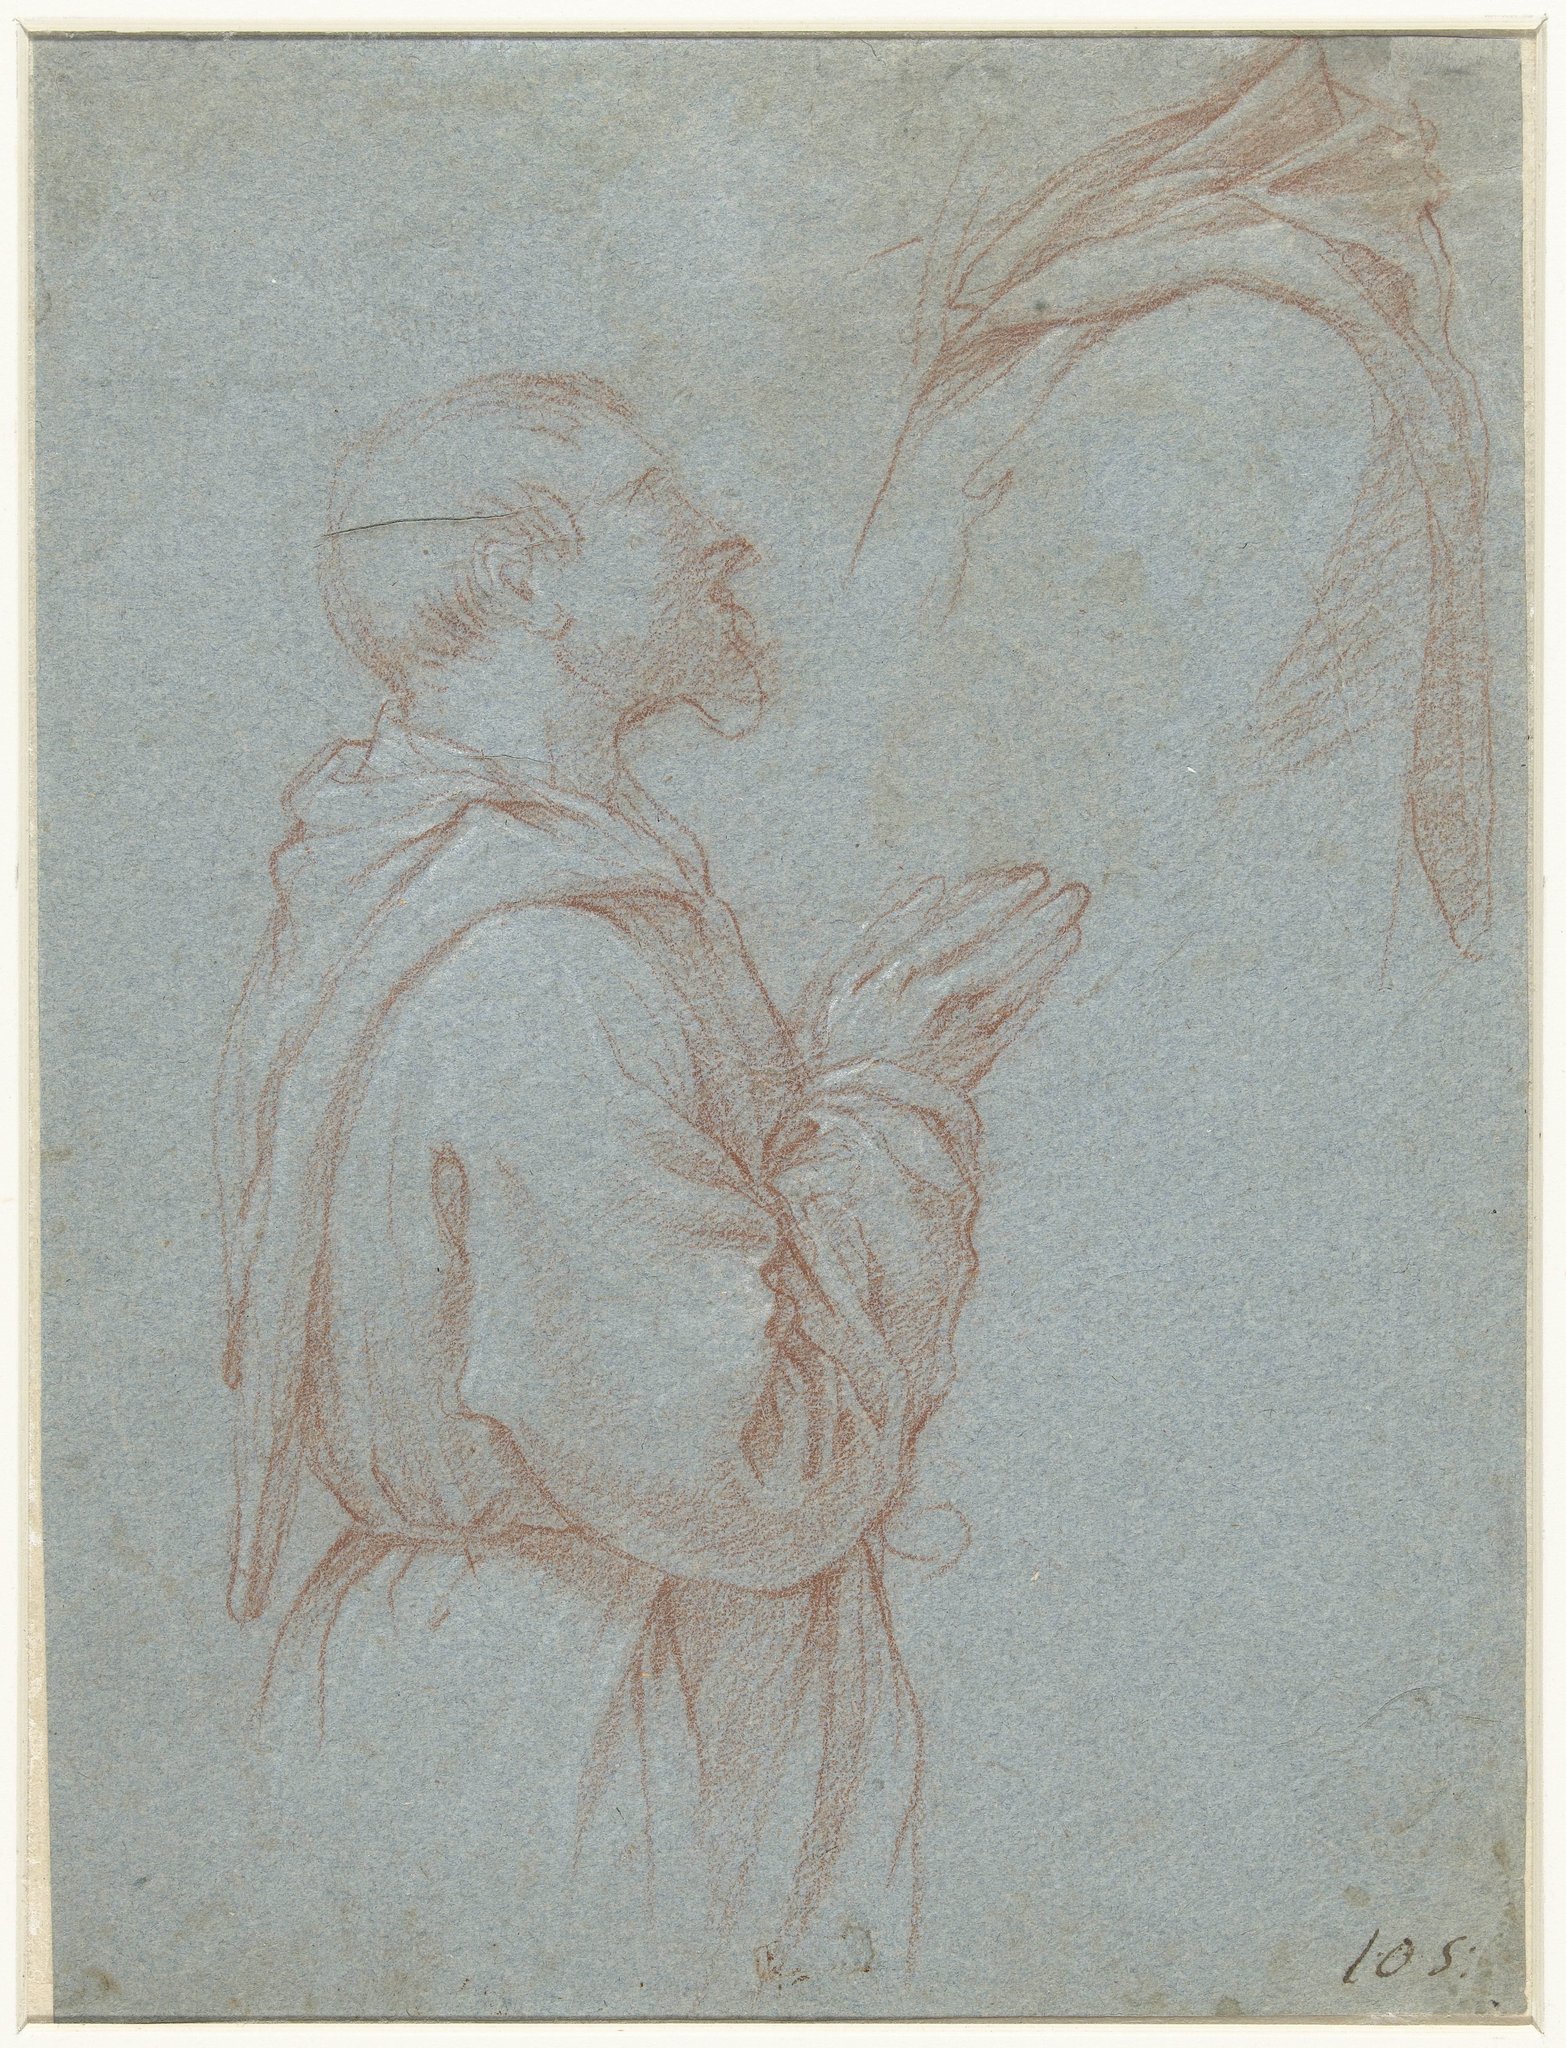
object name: drawing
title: Biddende monnik, en profil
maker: carlo maratta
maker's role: draughtsman, painter, print maker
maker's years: 1625-1713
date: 1635-1713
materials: chalk, paper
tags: monk(s), friar(s), kneeling figure, one person praying